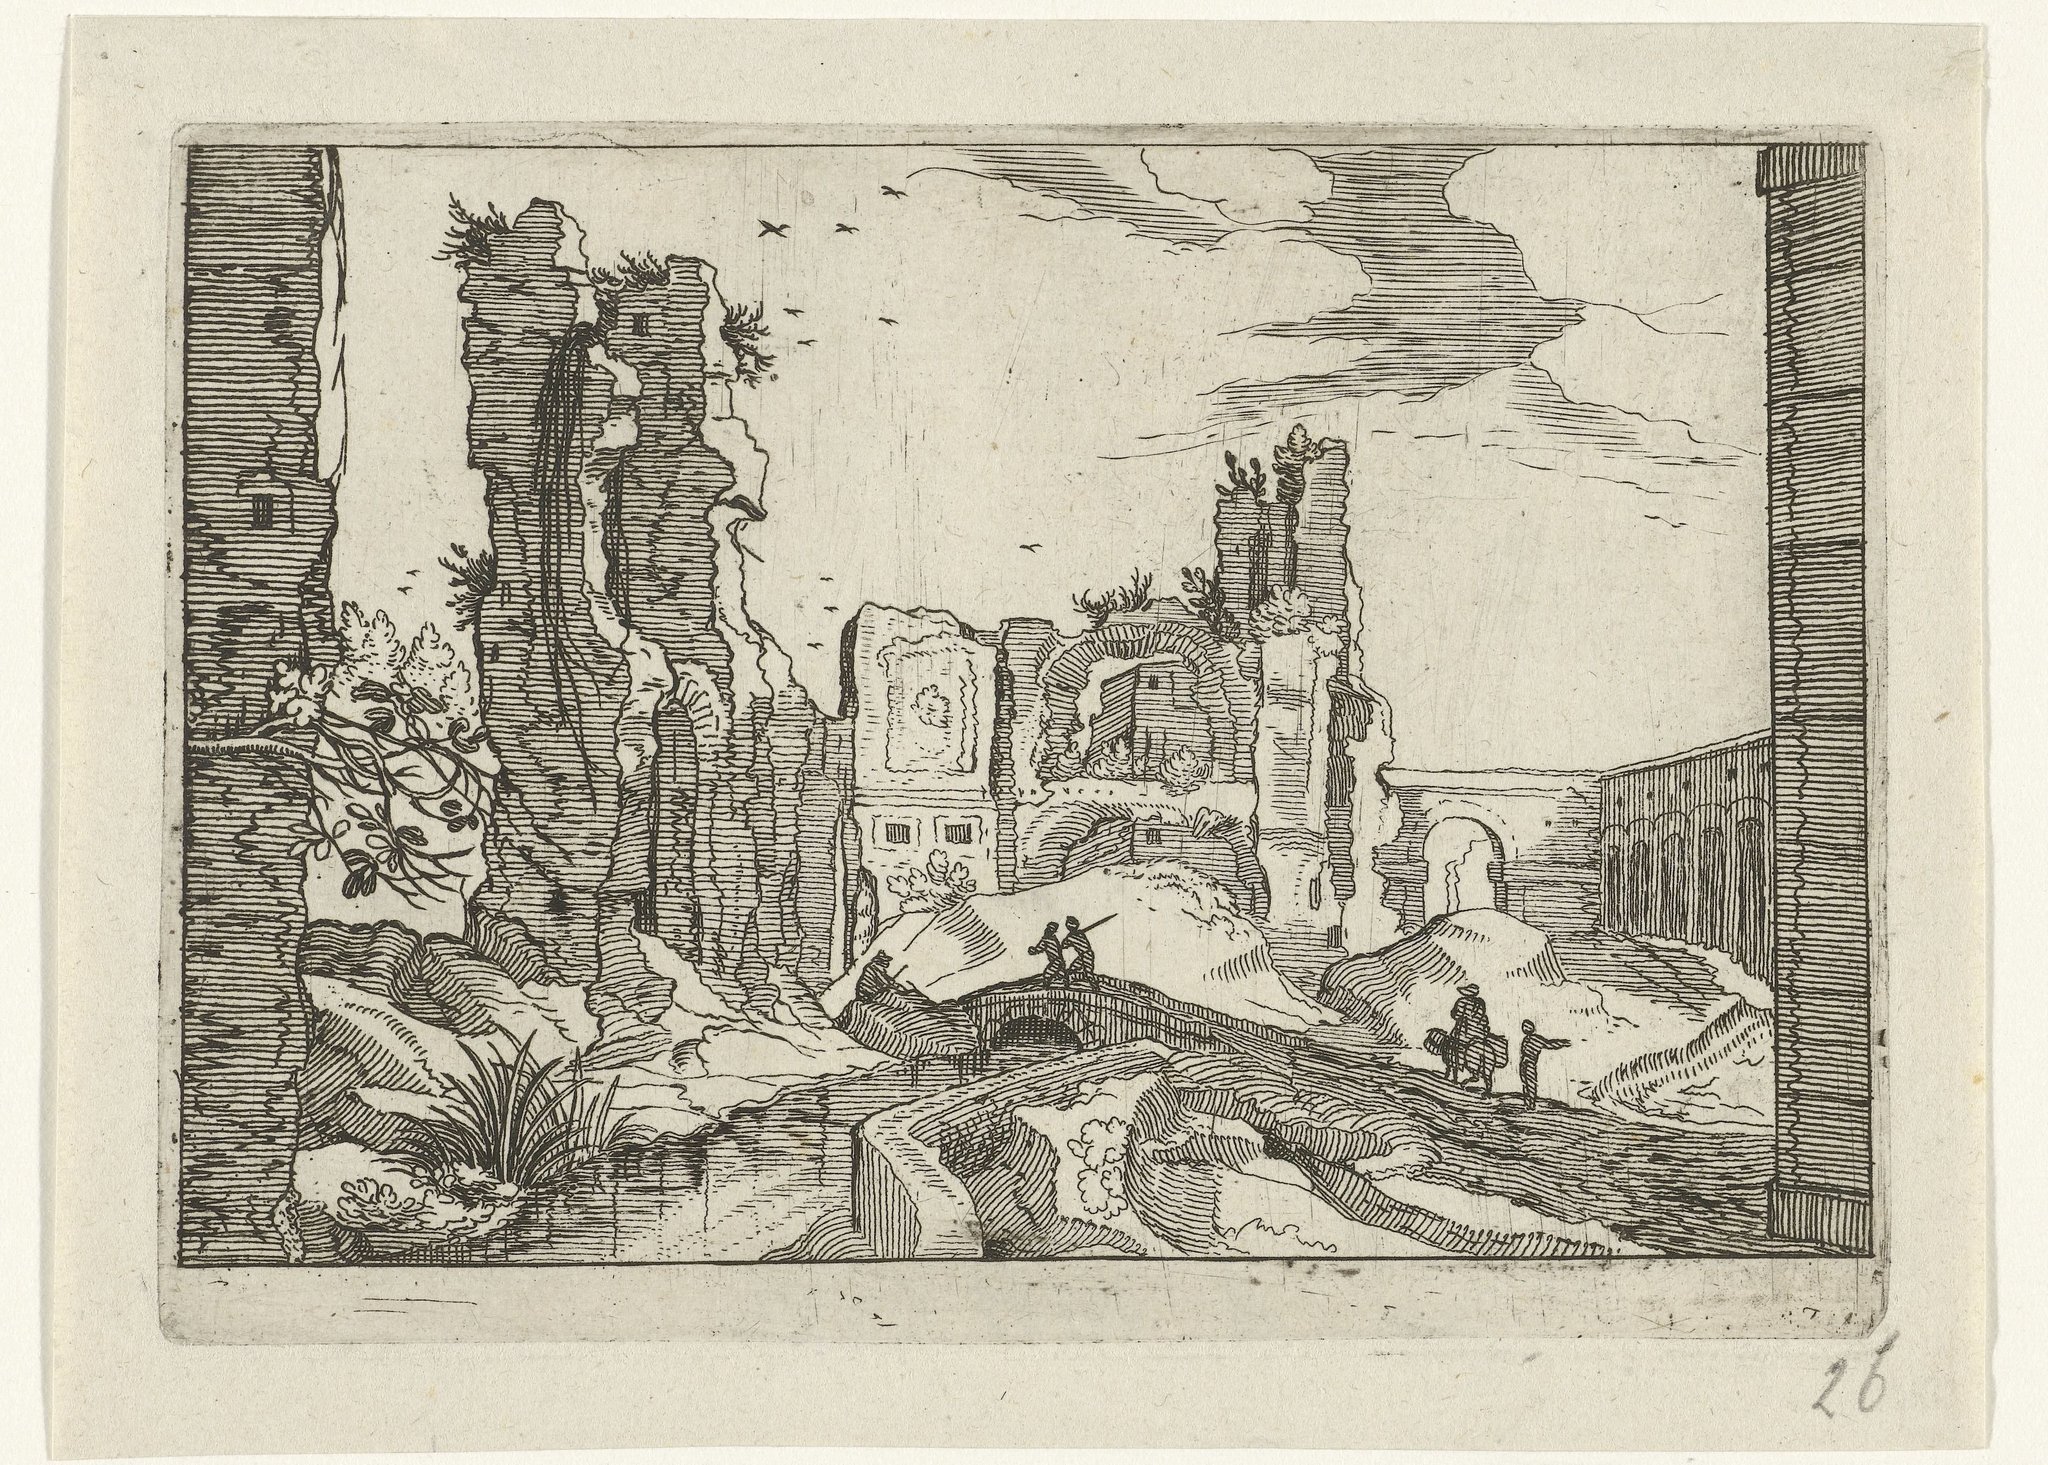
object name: print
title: Landschap met poort en ruïne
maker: Anonymous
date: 1594-1685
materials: paper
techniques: engraving, etching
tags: landscape with ruins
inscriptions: collector's mark: Lugt 2228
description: Aan het water liggen begroeide ruïnes, wellicht de Porta Furba. Rechts een poort. Rechts op de voorgrond een weg met een bereden ezel en een wandelaar. Op de brug lopen twee figuren. Prent uit een serie Romeinse ruïnes, bestaande uit kopieën naar een prentserie van Willem van Nieulandt.